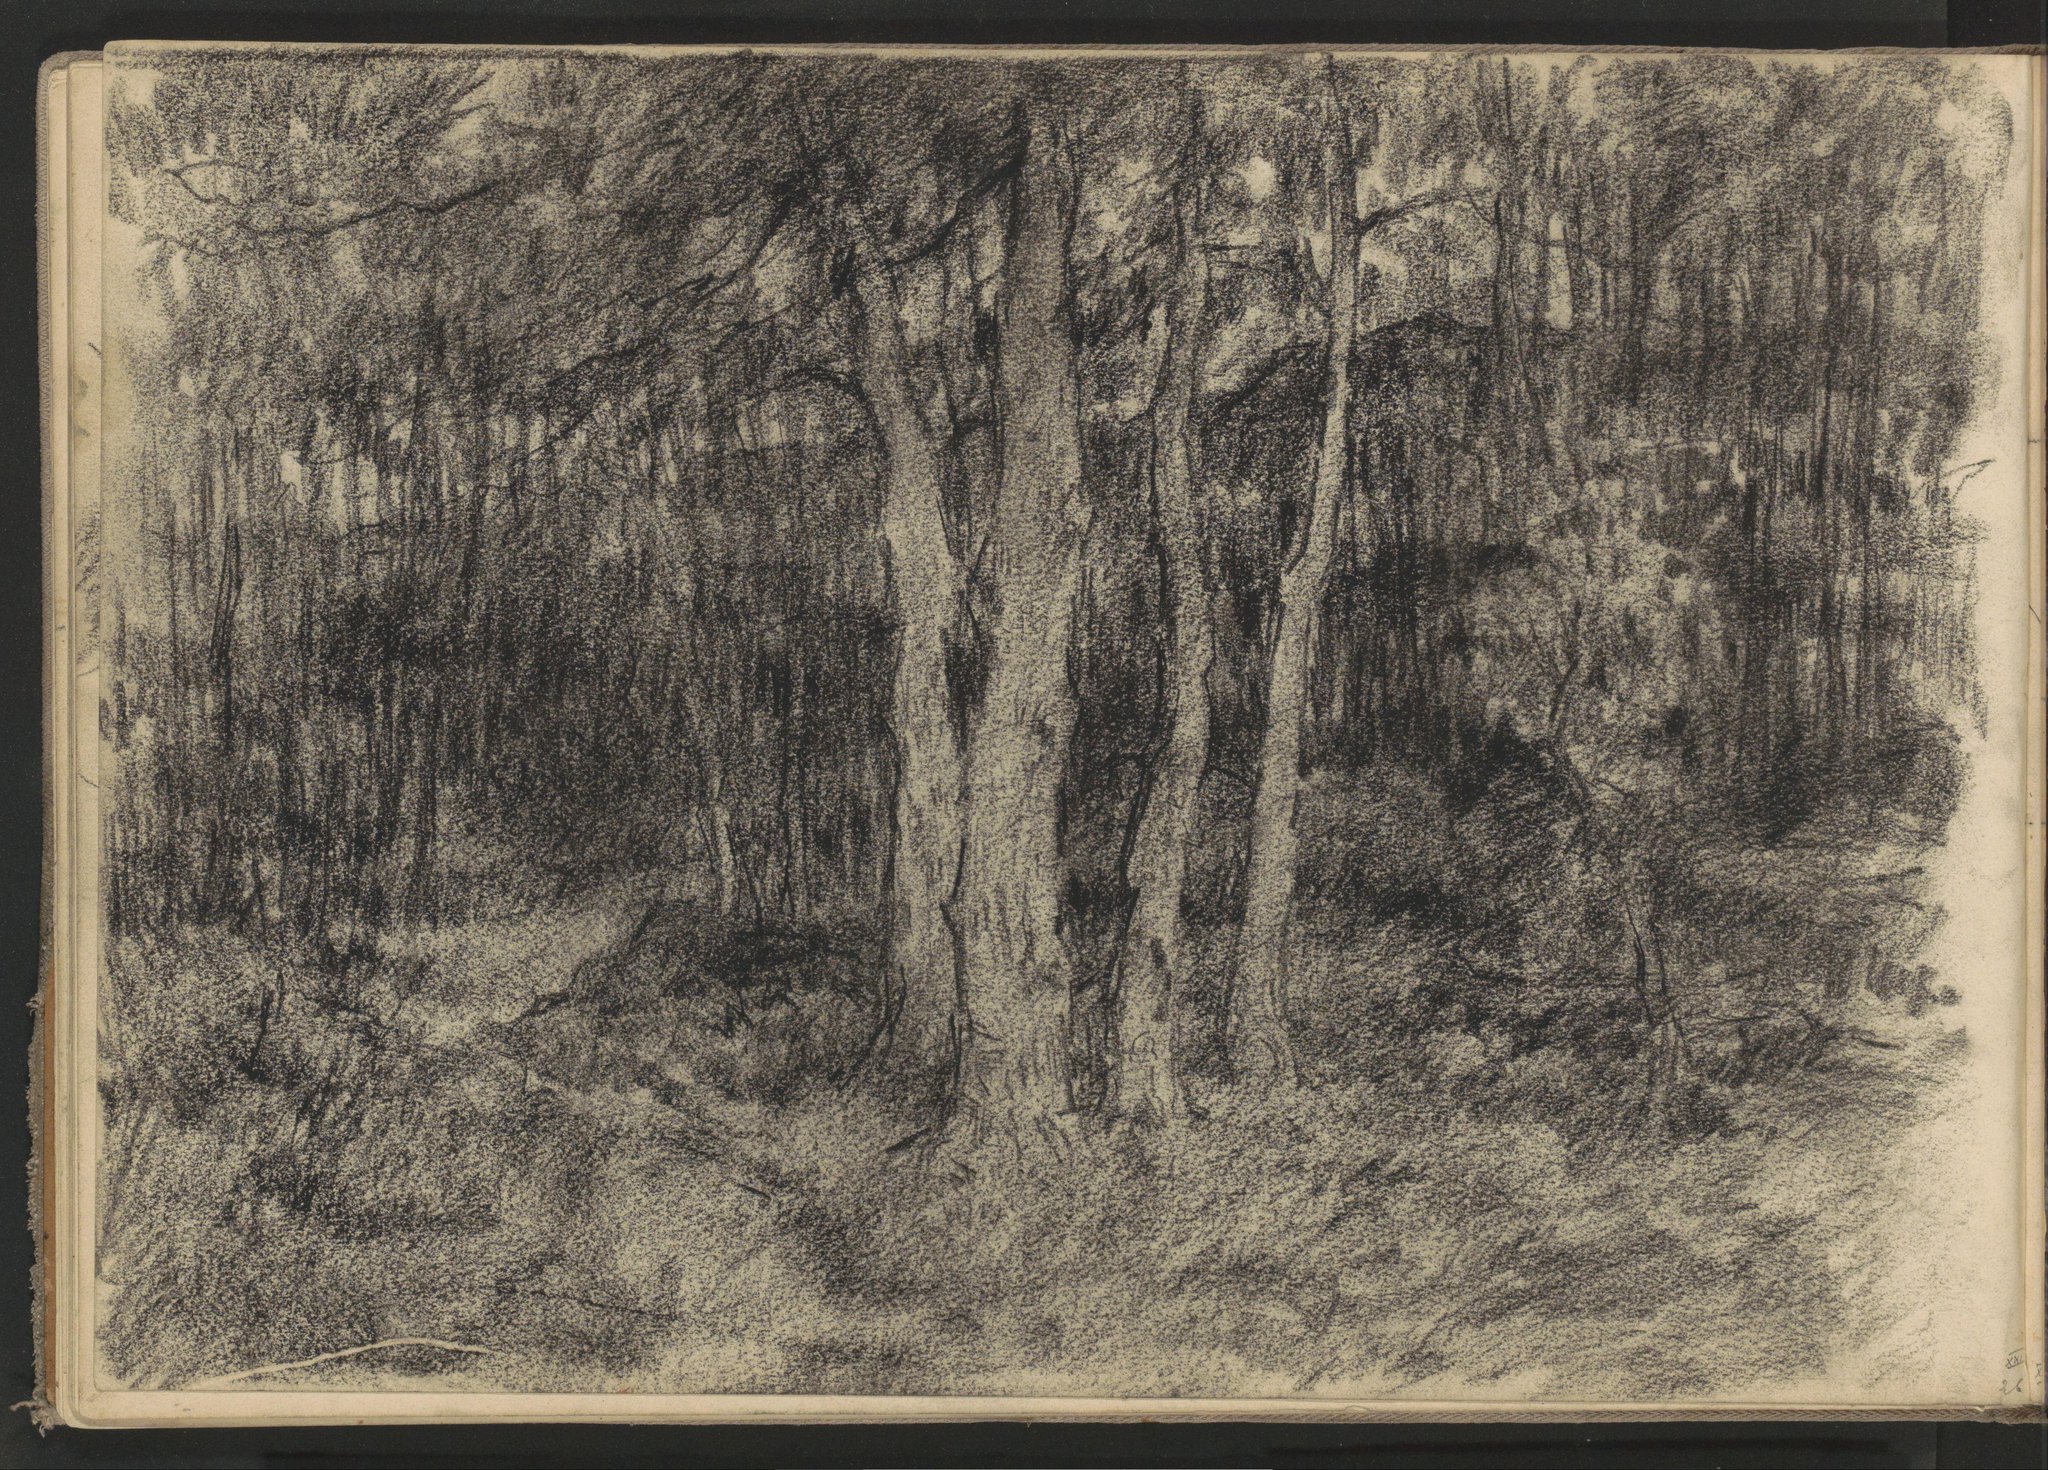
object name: sketchbook leaf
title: Bosgezicht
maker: egbert rubertus derk schaap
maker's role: draughtsman, painter, print maker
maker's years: 1862-1939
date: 1891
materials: chalk, paper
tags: forest, wood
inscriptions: number: ‘XXI’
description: Pagina 26 uit een schetsboek met 64 pagina's.